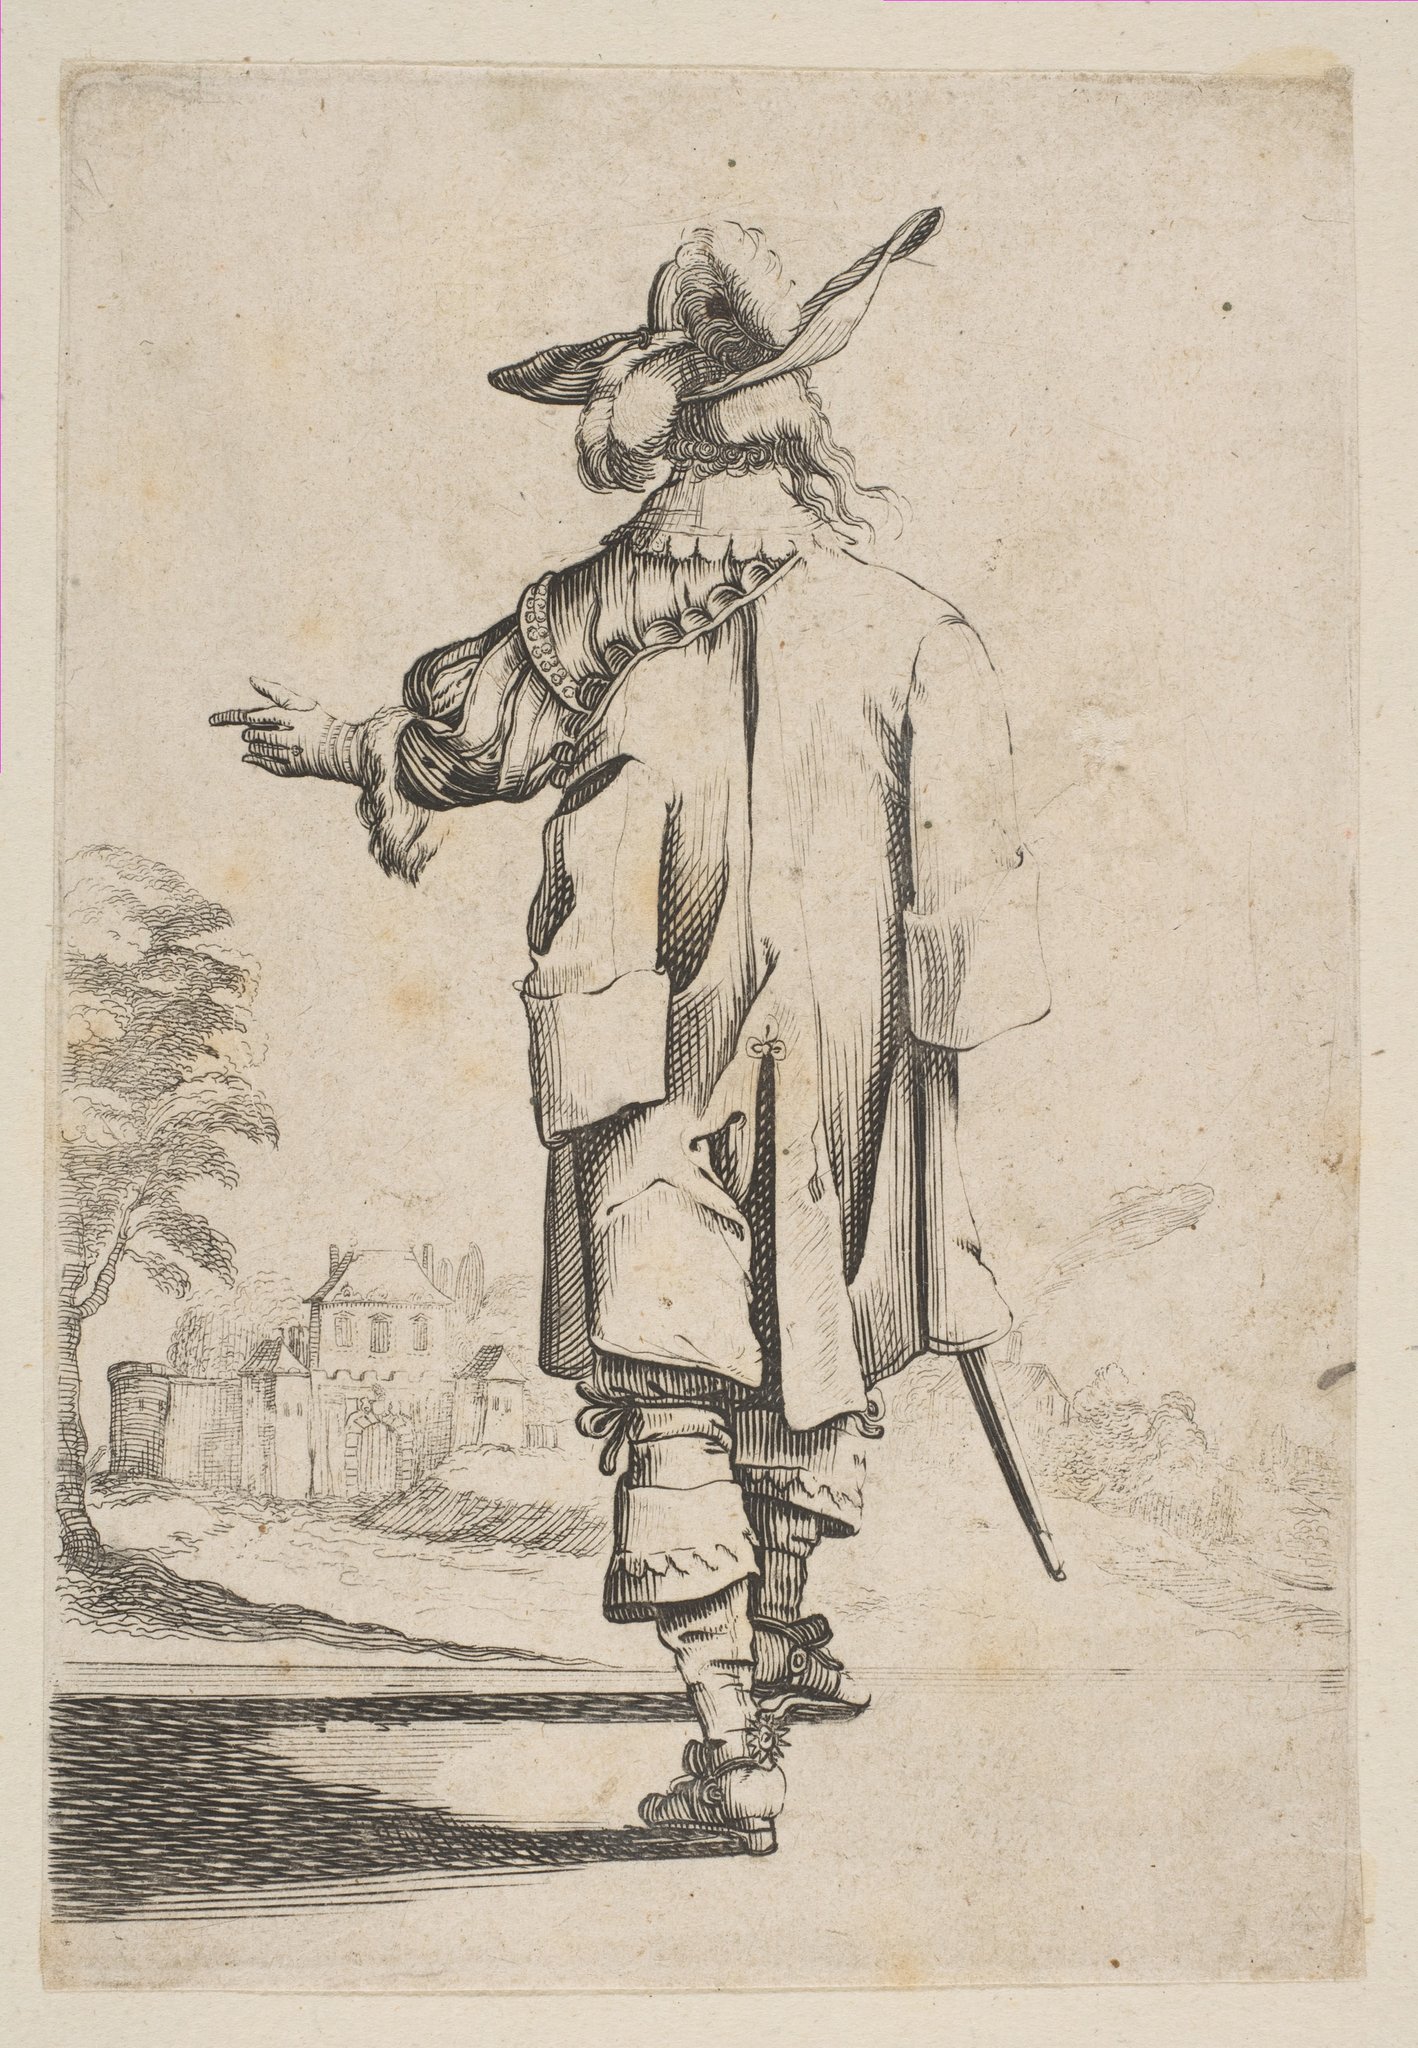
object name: print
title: Gentleman Seen from the Back Pointing towards a Chateau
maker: anonymous, french, 17th century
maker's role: artist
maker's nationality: french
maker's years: 1600-1700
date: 1629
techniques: etching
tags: men